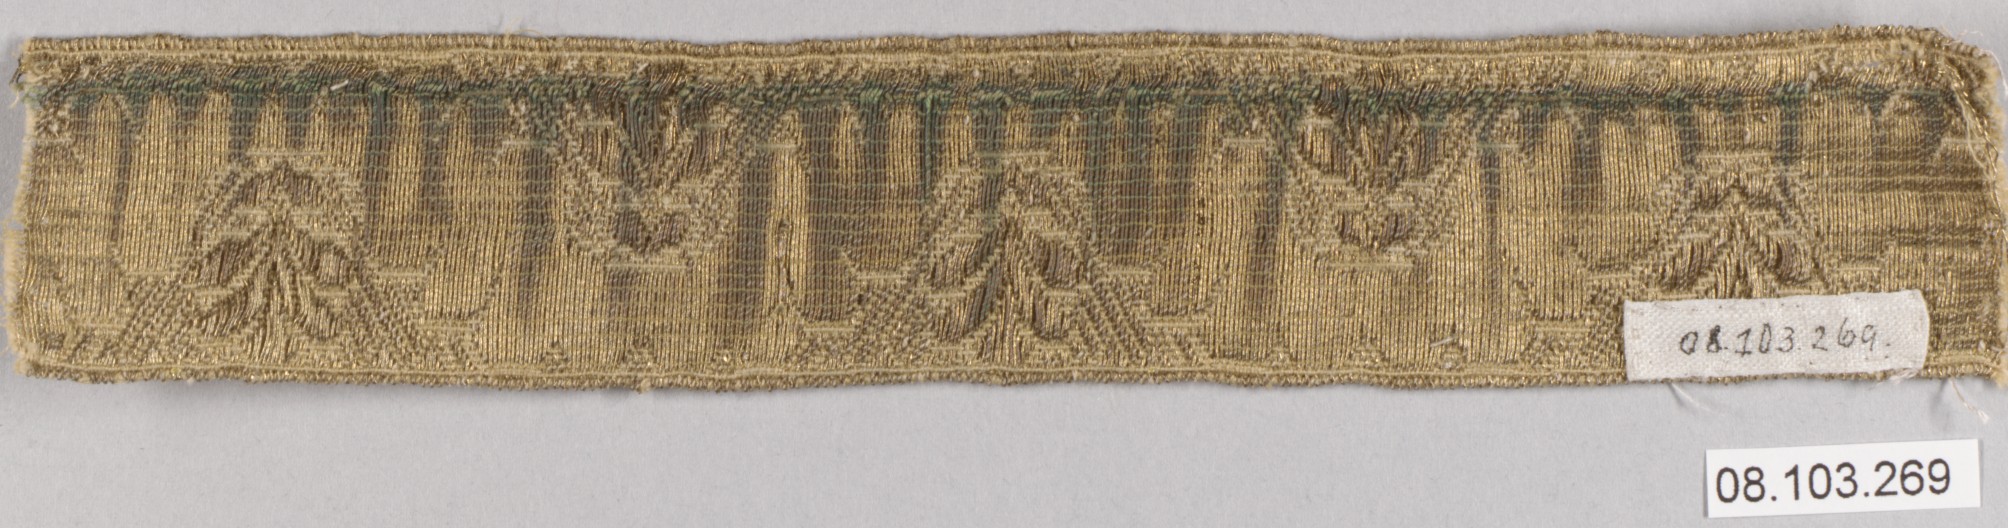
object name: galloon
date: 1601-1800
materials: metal thread